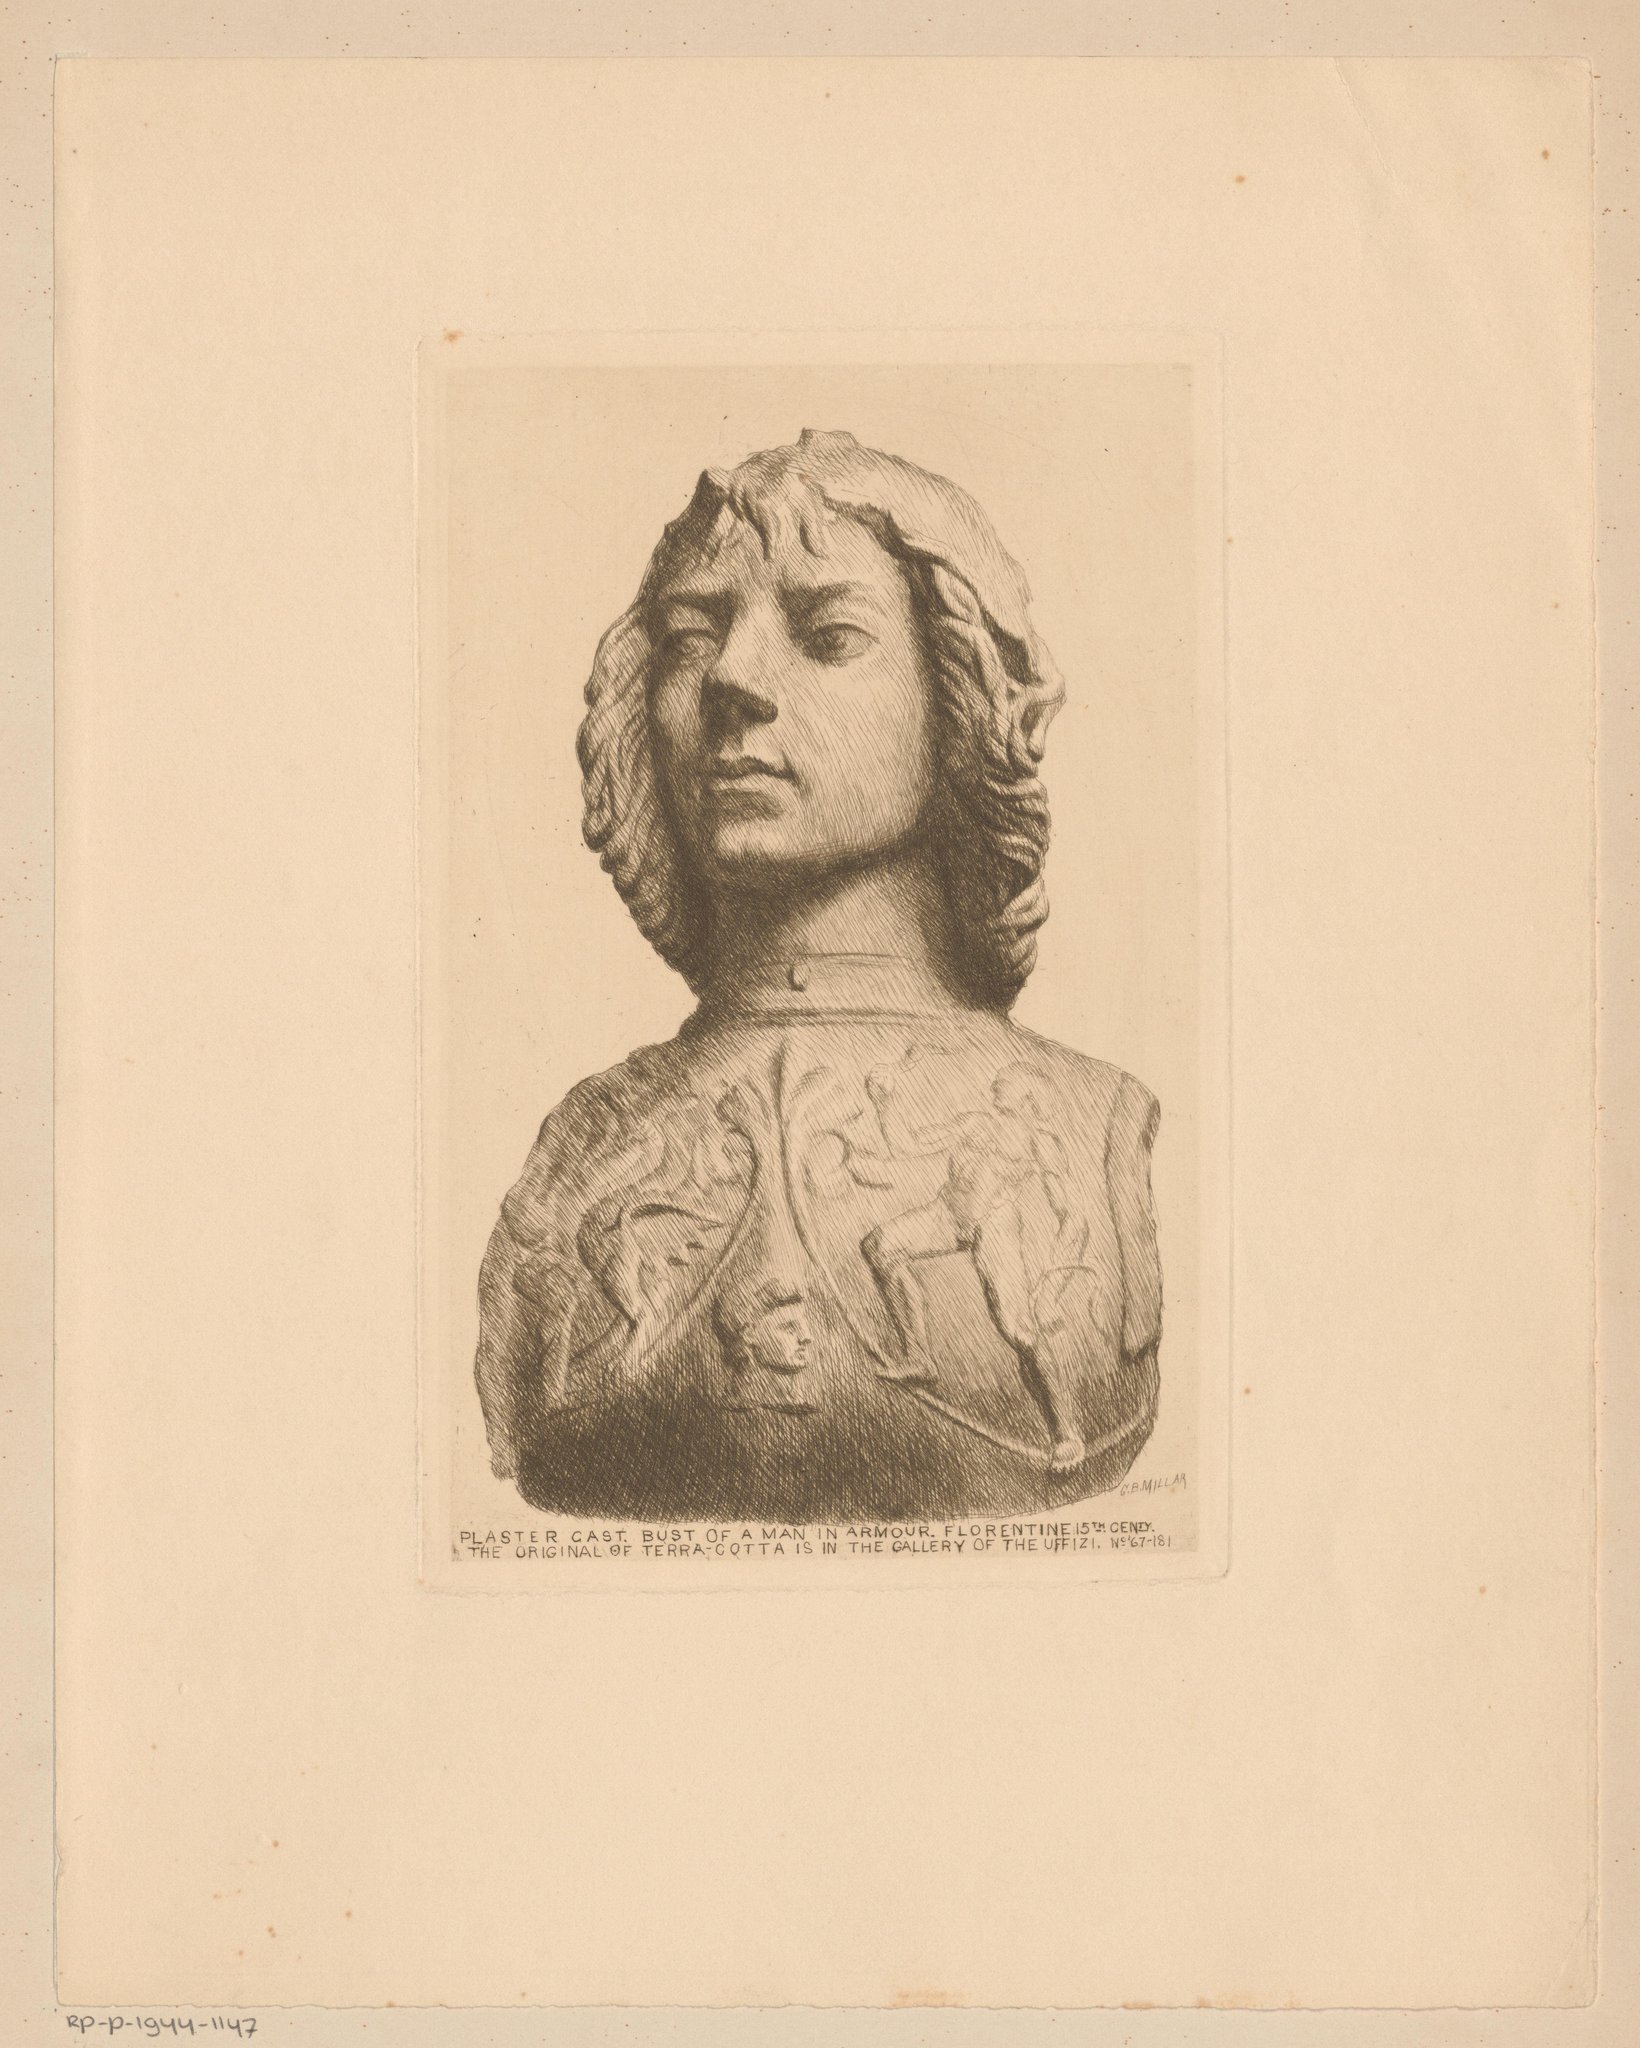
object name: print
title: Buste van een man, mogelijk Guiliano de Medici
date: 1800-1950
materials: paper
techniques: etching, intaglio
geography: galleria degli uffizi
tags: politician, parts of the human body (skeleton excepted), historical persons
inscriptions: collector's mark: Lugt 2228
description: Met tweeregelig onderschrift in het Engels.